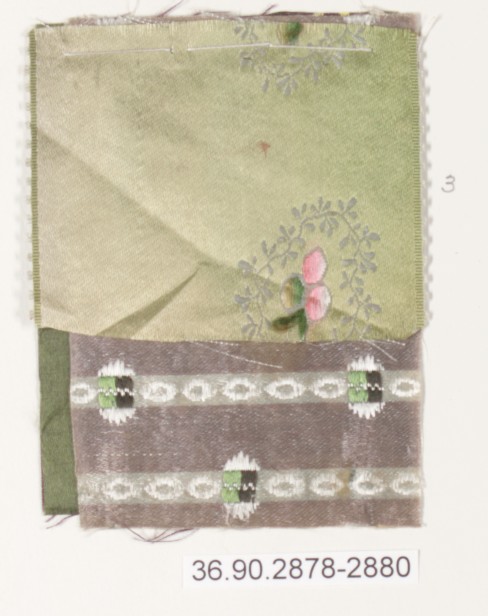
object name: piece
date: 1801-1900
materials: silk